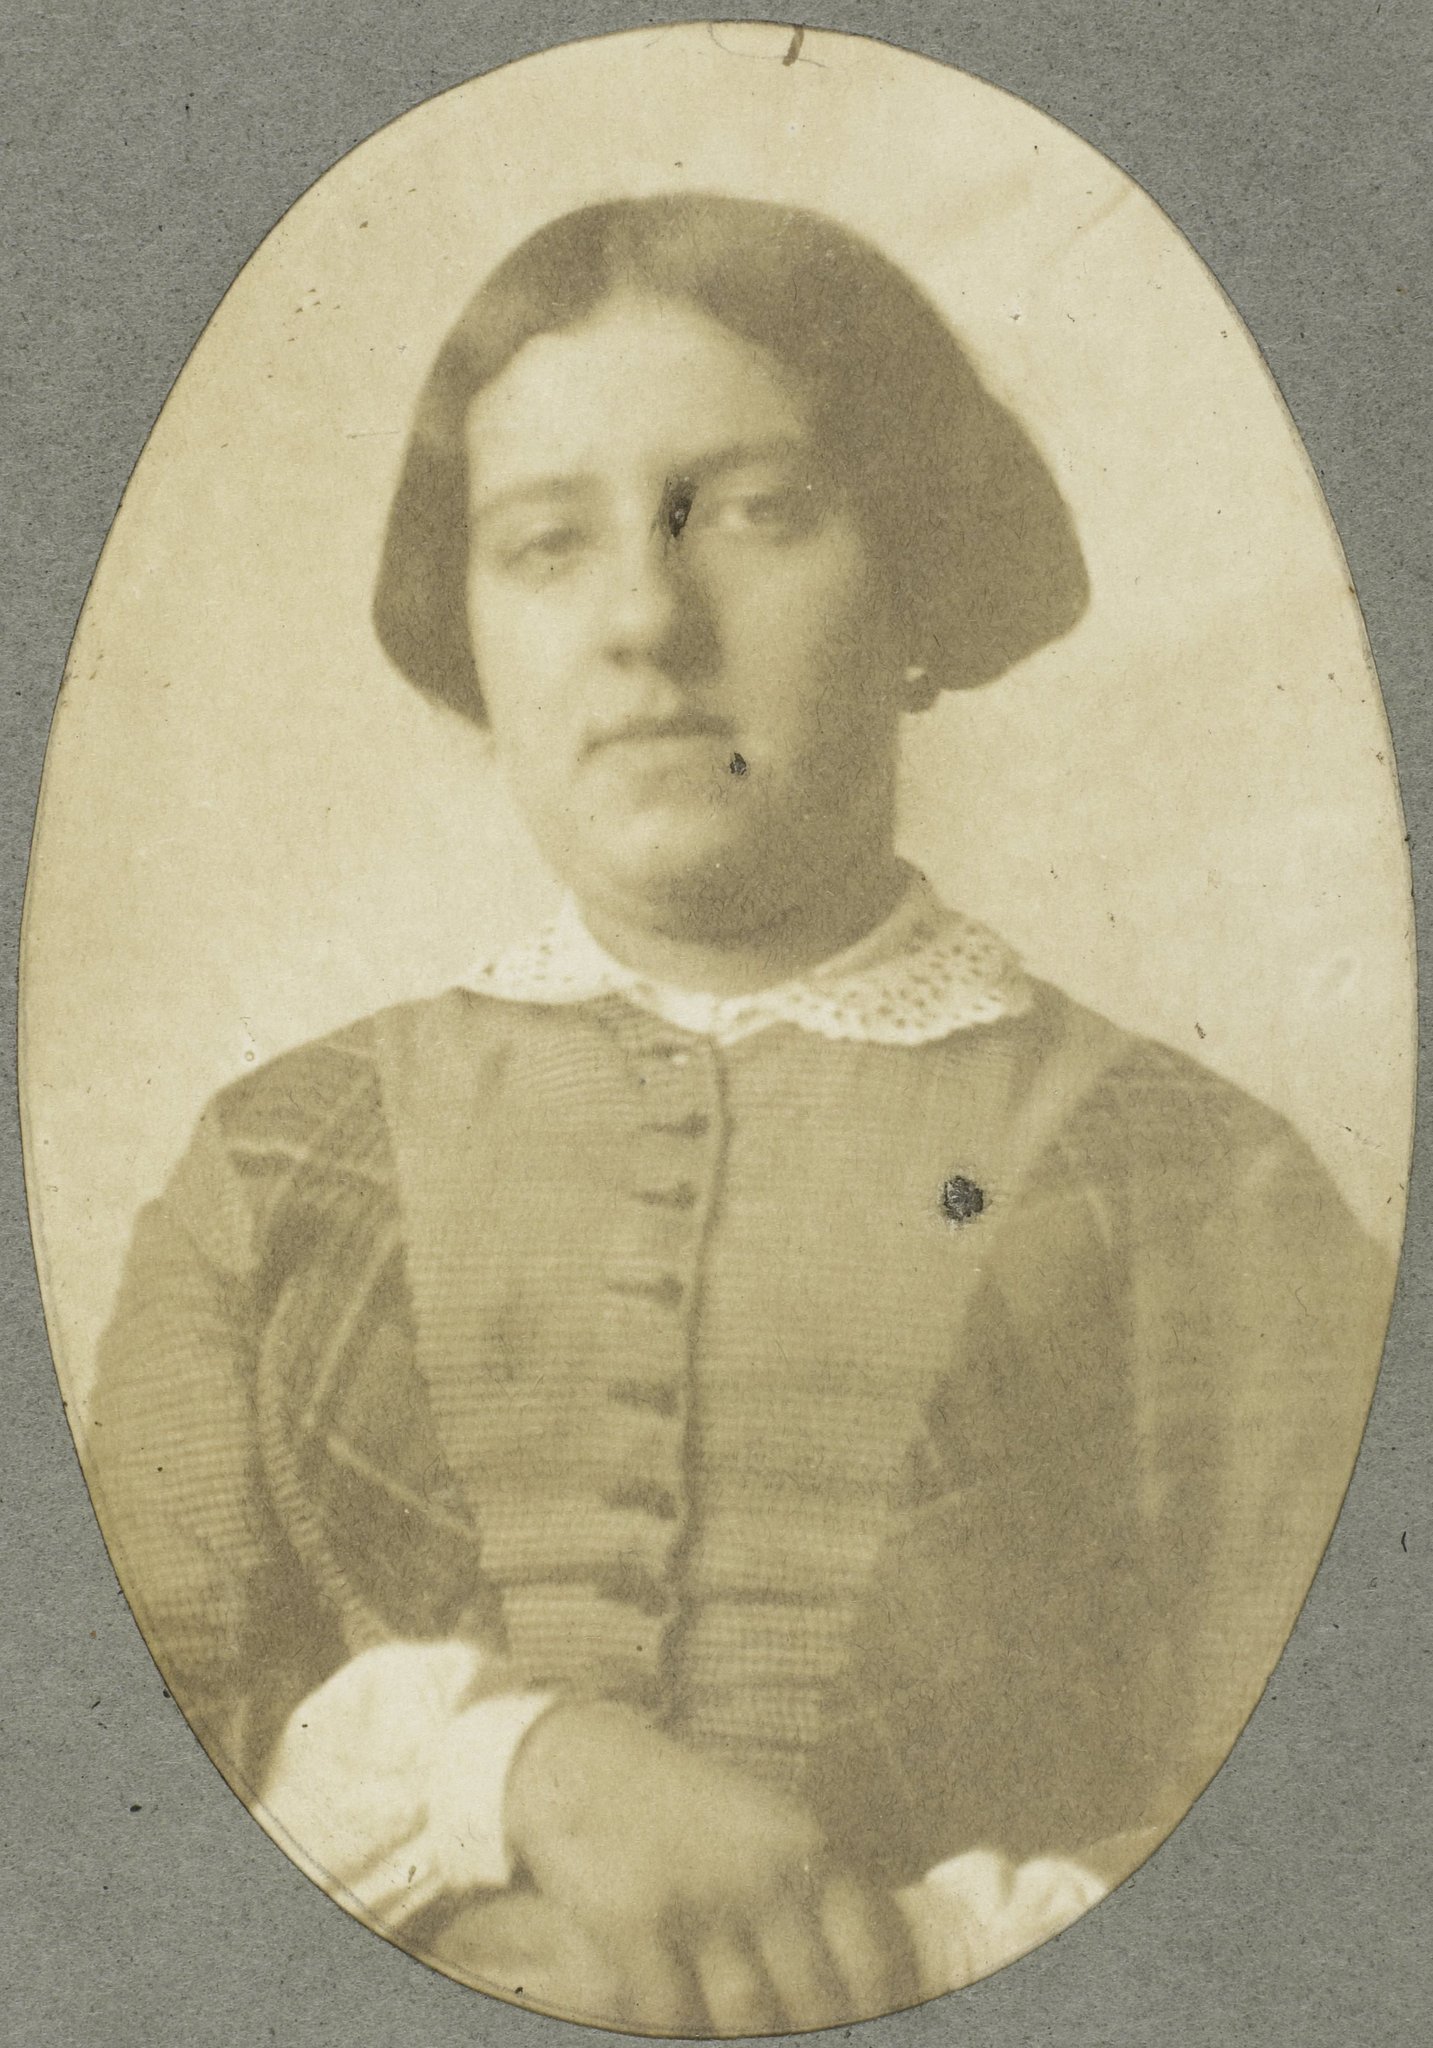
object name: photograph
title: Portret van Charlotte Asser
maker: eduard isaac asser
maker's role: amateurfotograaf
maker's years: 1809-1894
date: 1852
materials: cardboard, paper, photographic support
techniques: salted paper print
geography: amsterdam